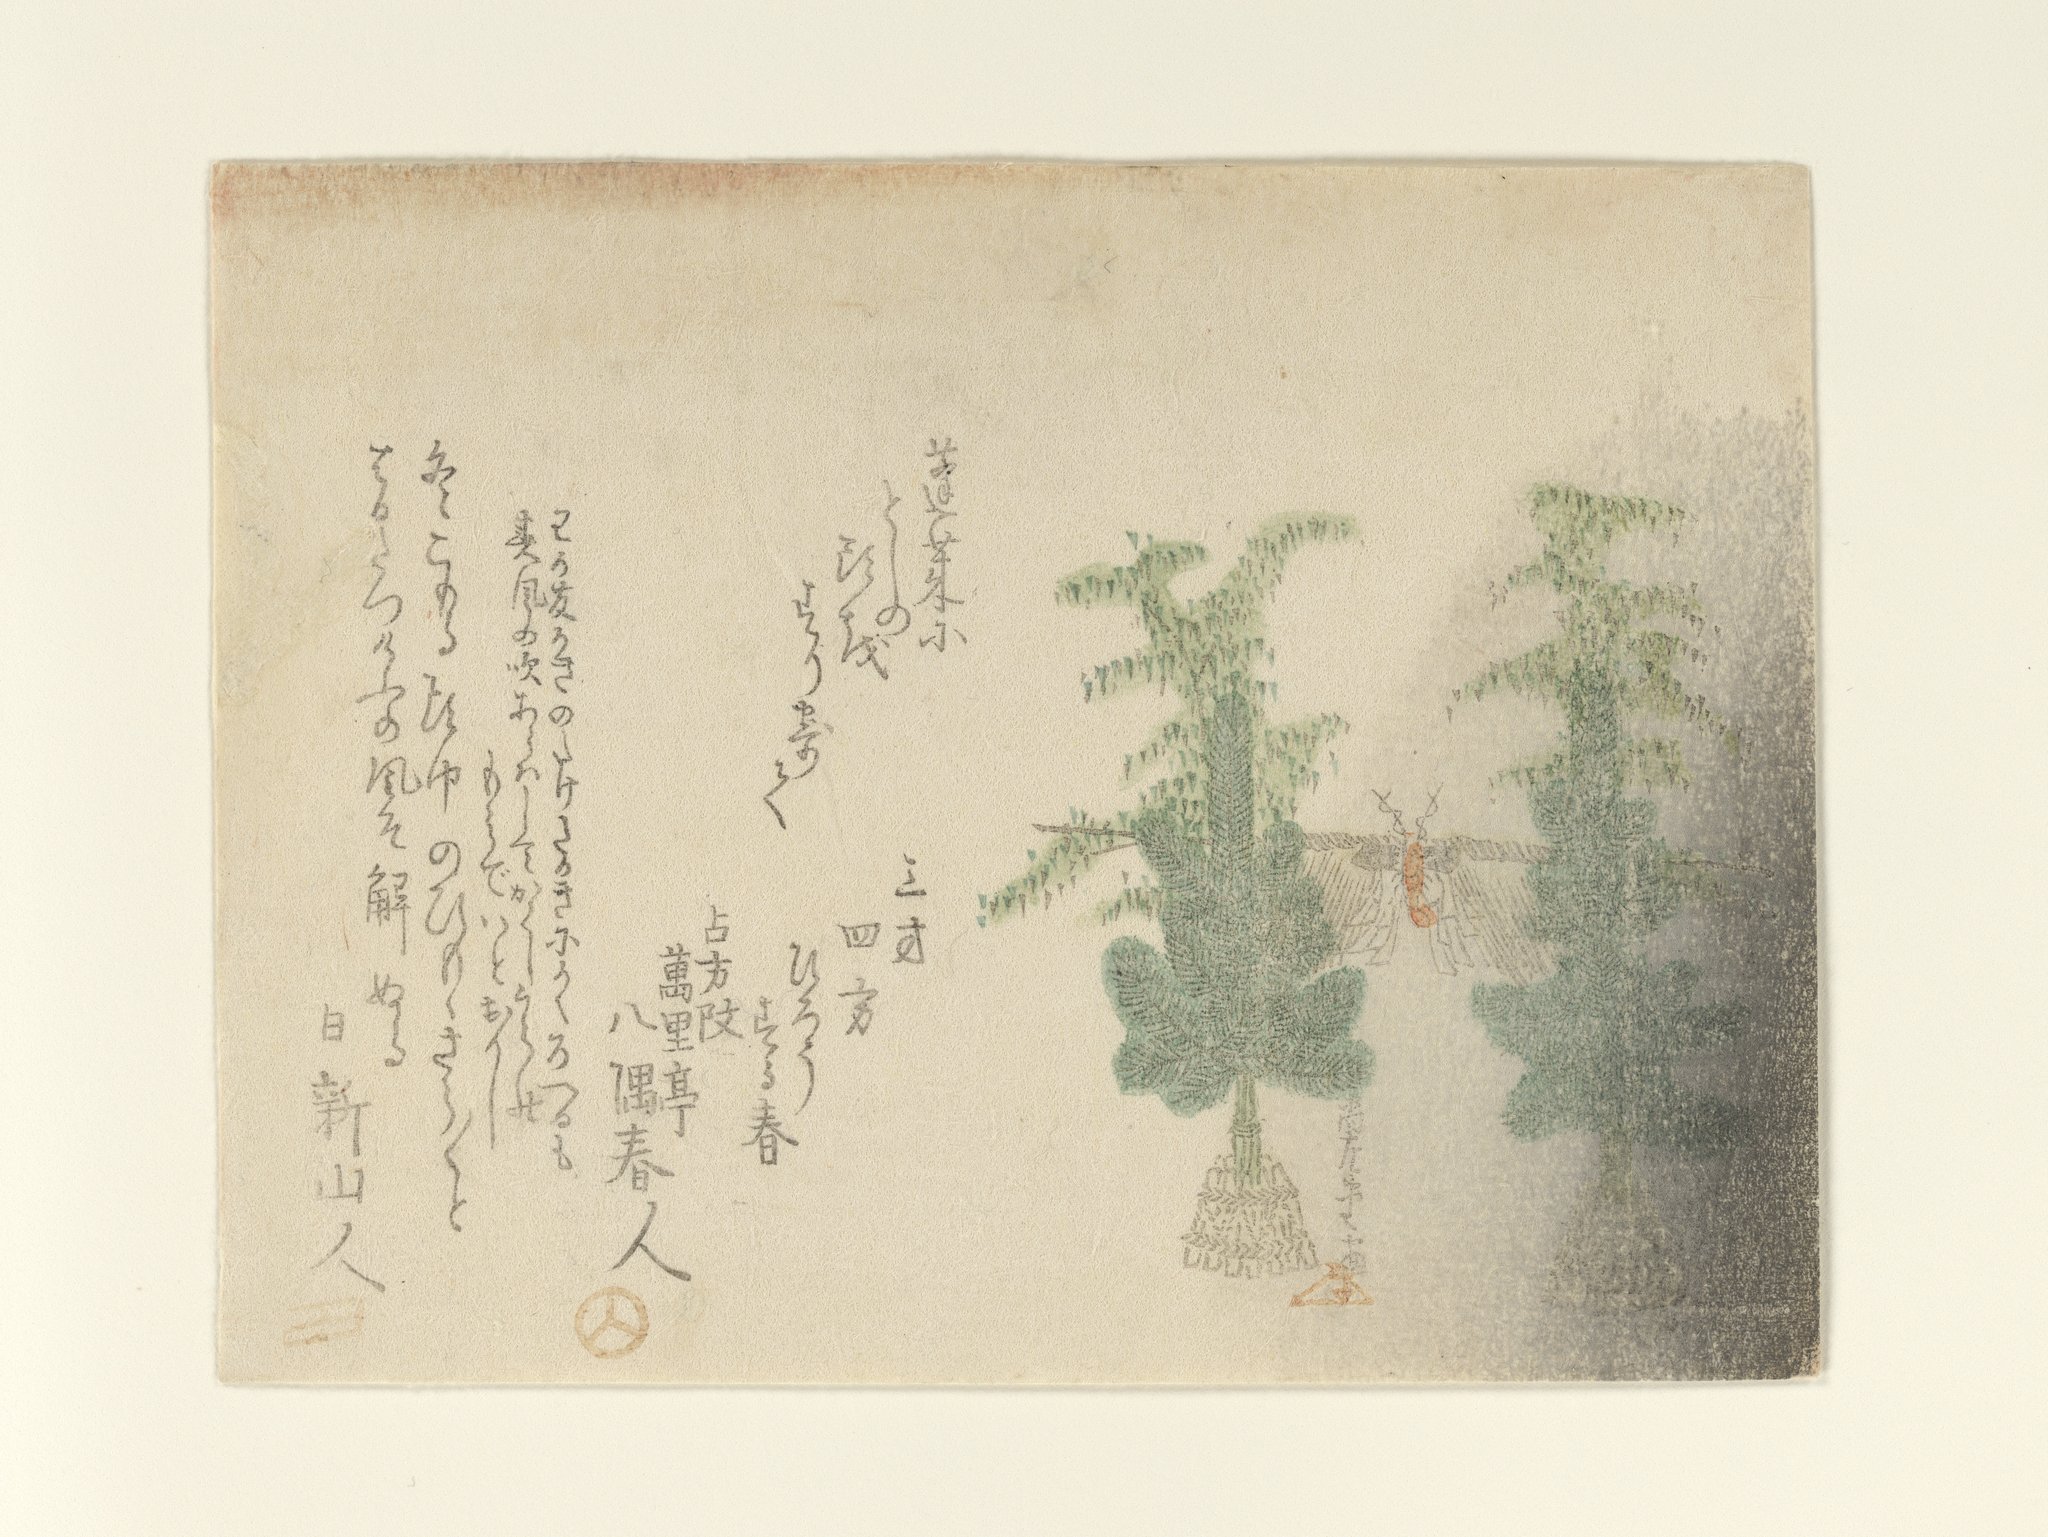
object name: print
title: Pair of Kadomatsu (pine decorations)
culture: japanese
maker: kubo shunman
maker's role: artist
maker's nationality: japanese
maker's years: 1757-1820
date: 1797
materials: ink, paper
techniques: surimono, woodblock print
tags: trees